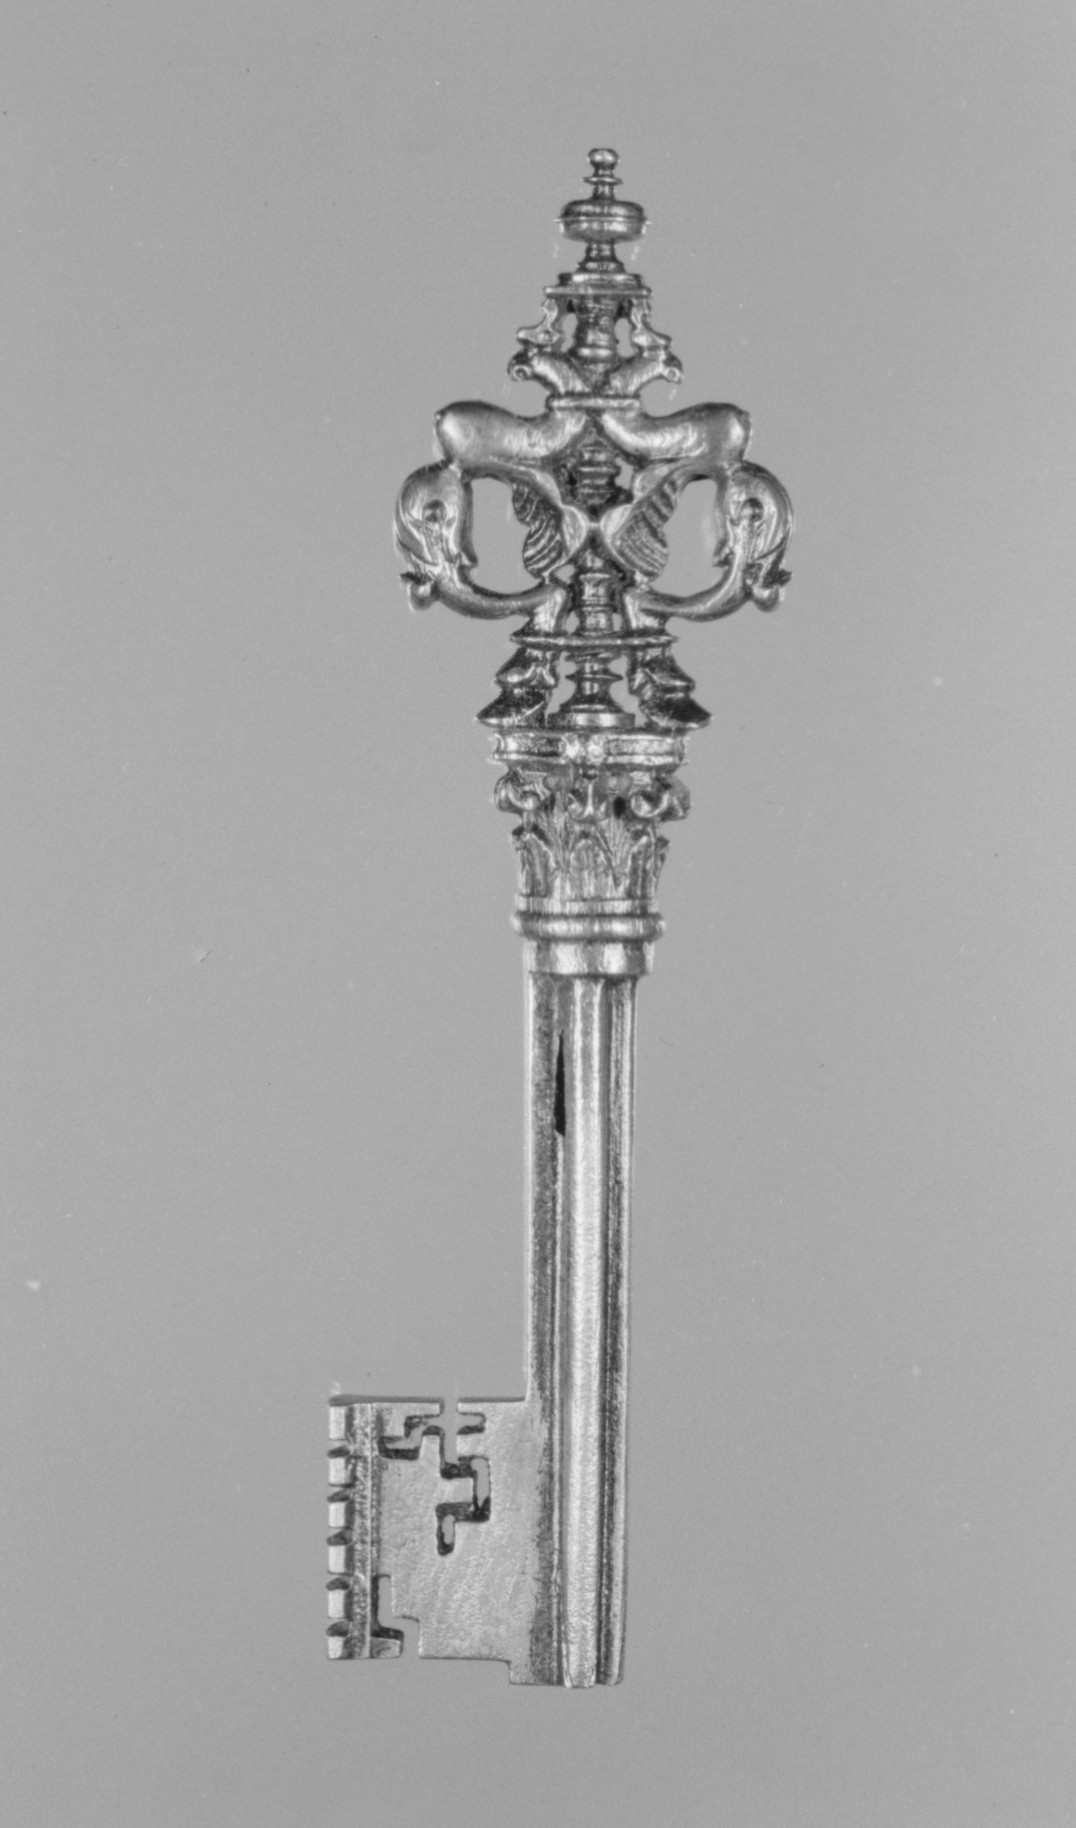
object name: key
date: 1801-1900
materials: iron